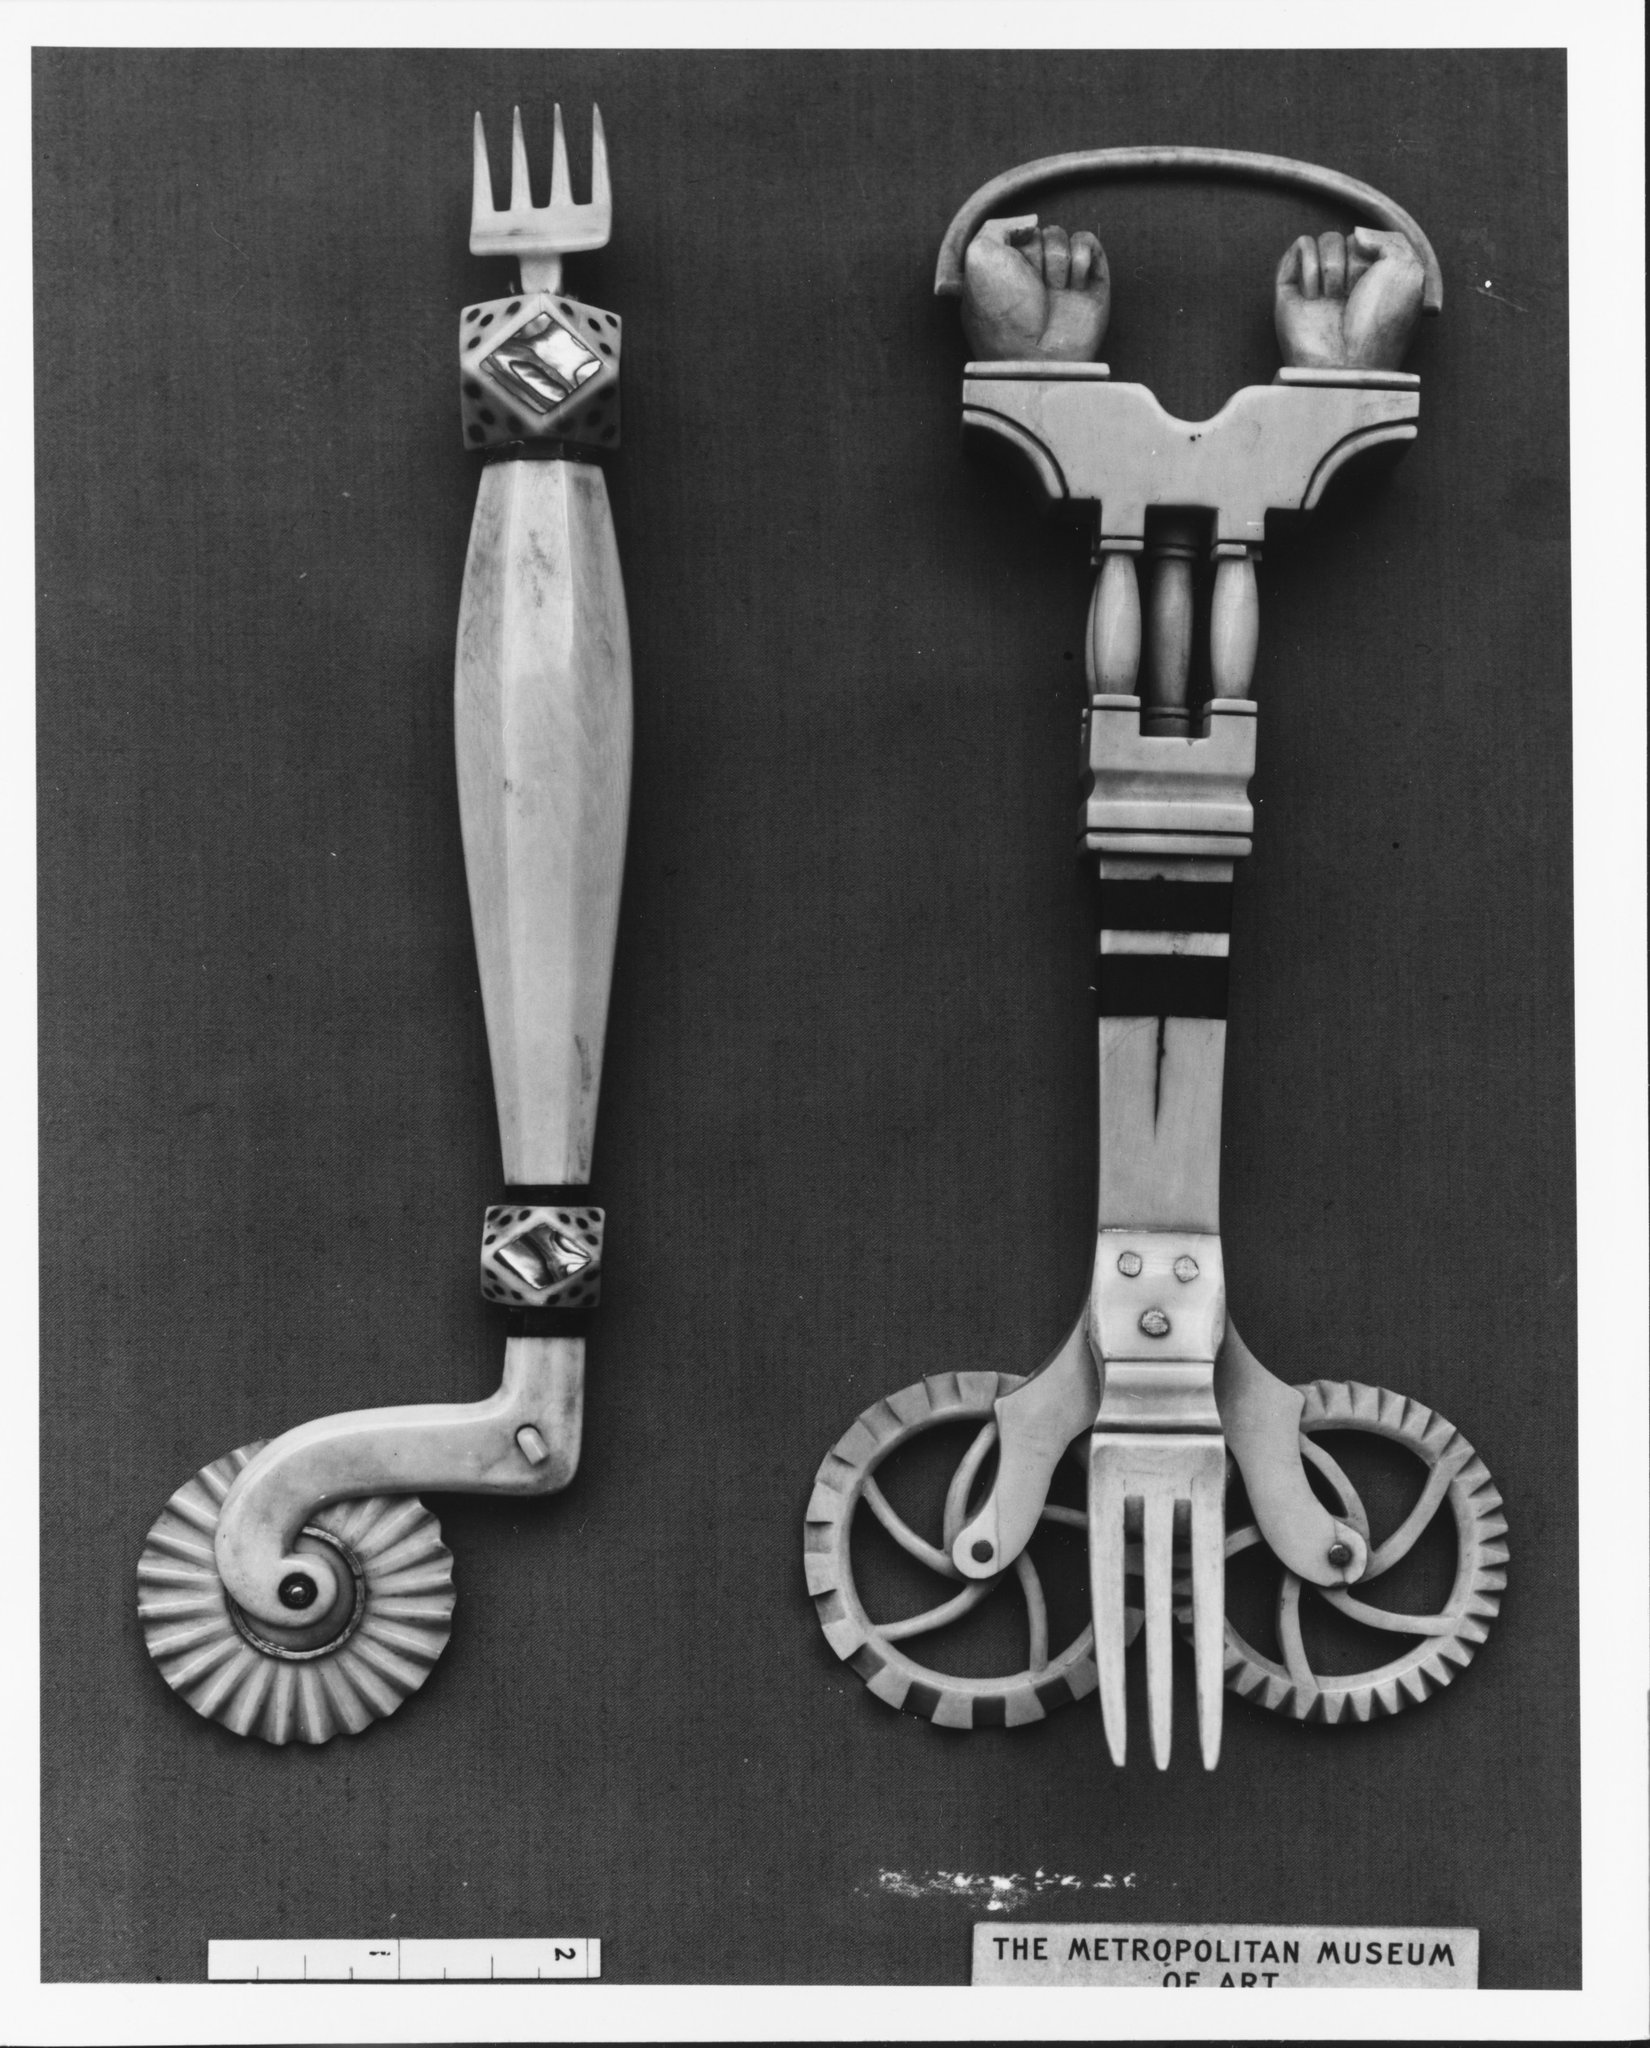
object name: jagging wheel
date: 1770-1800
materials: ivory